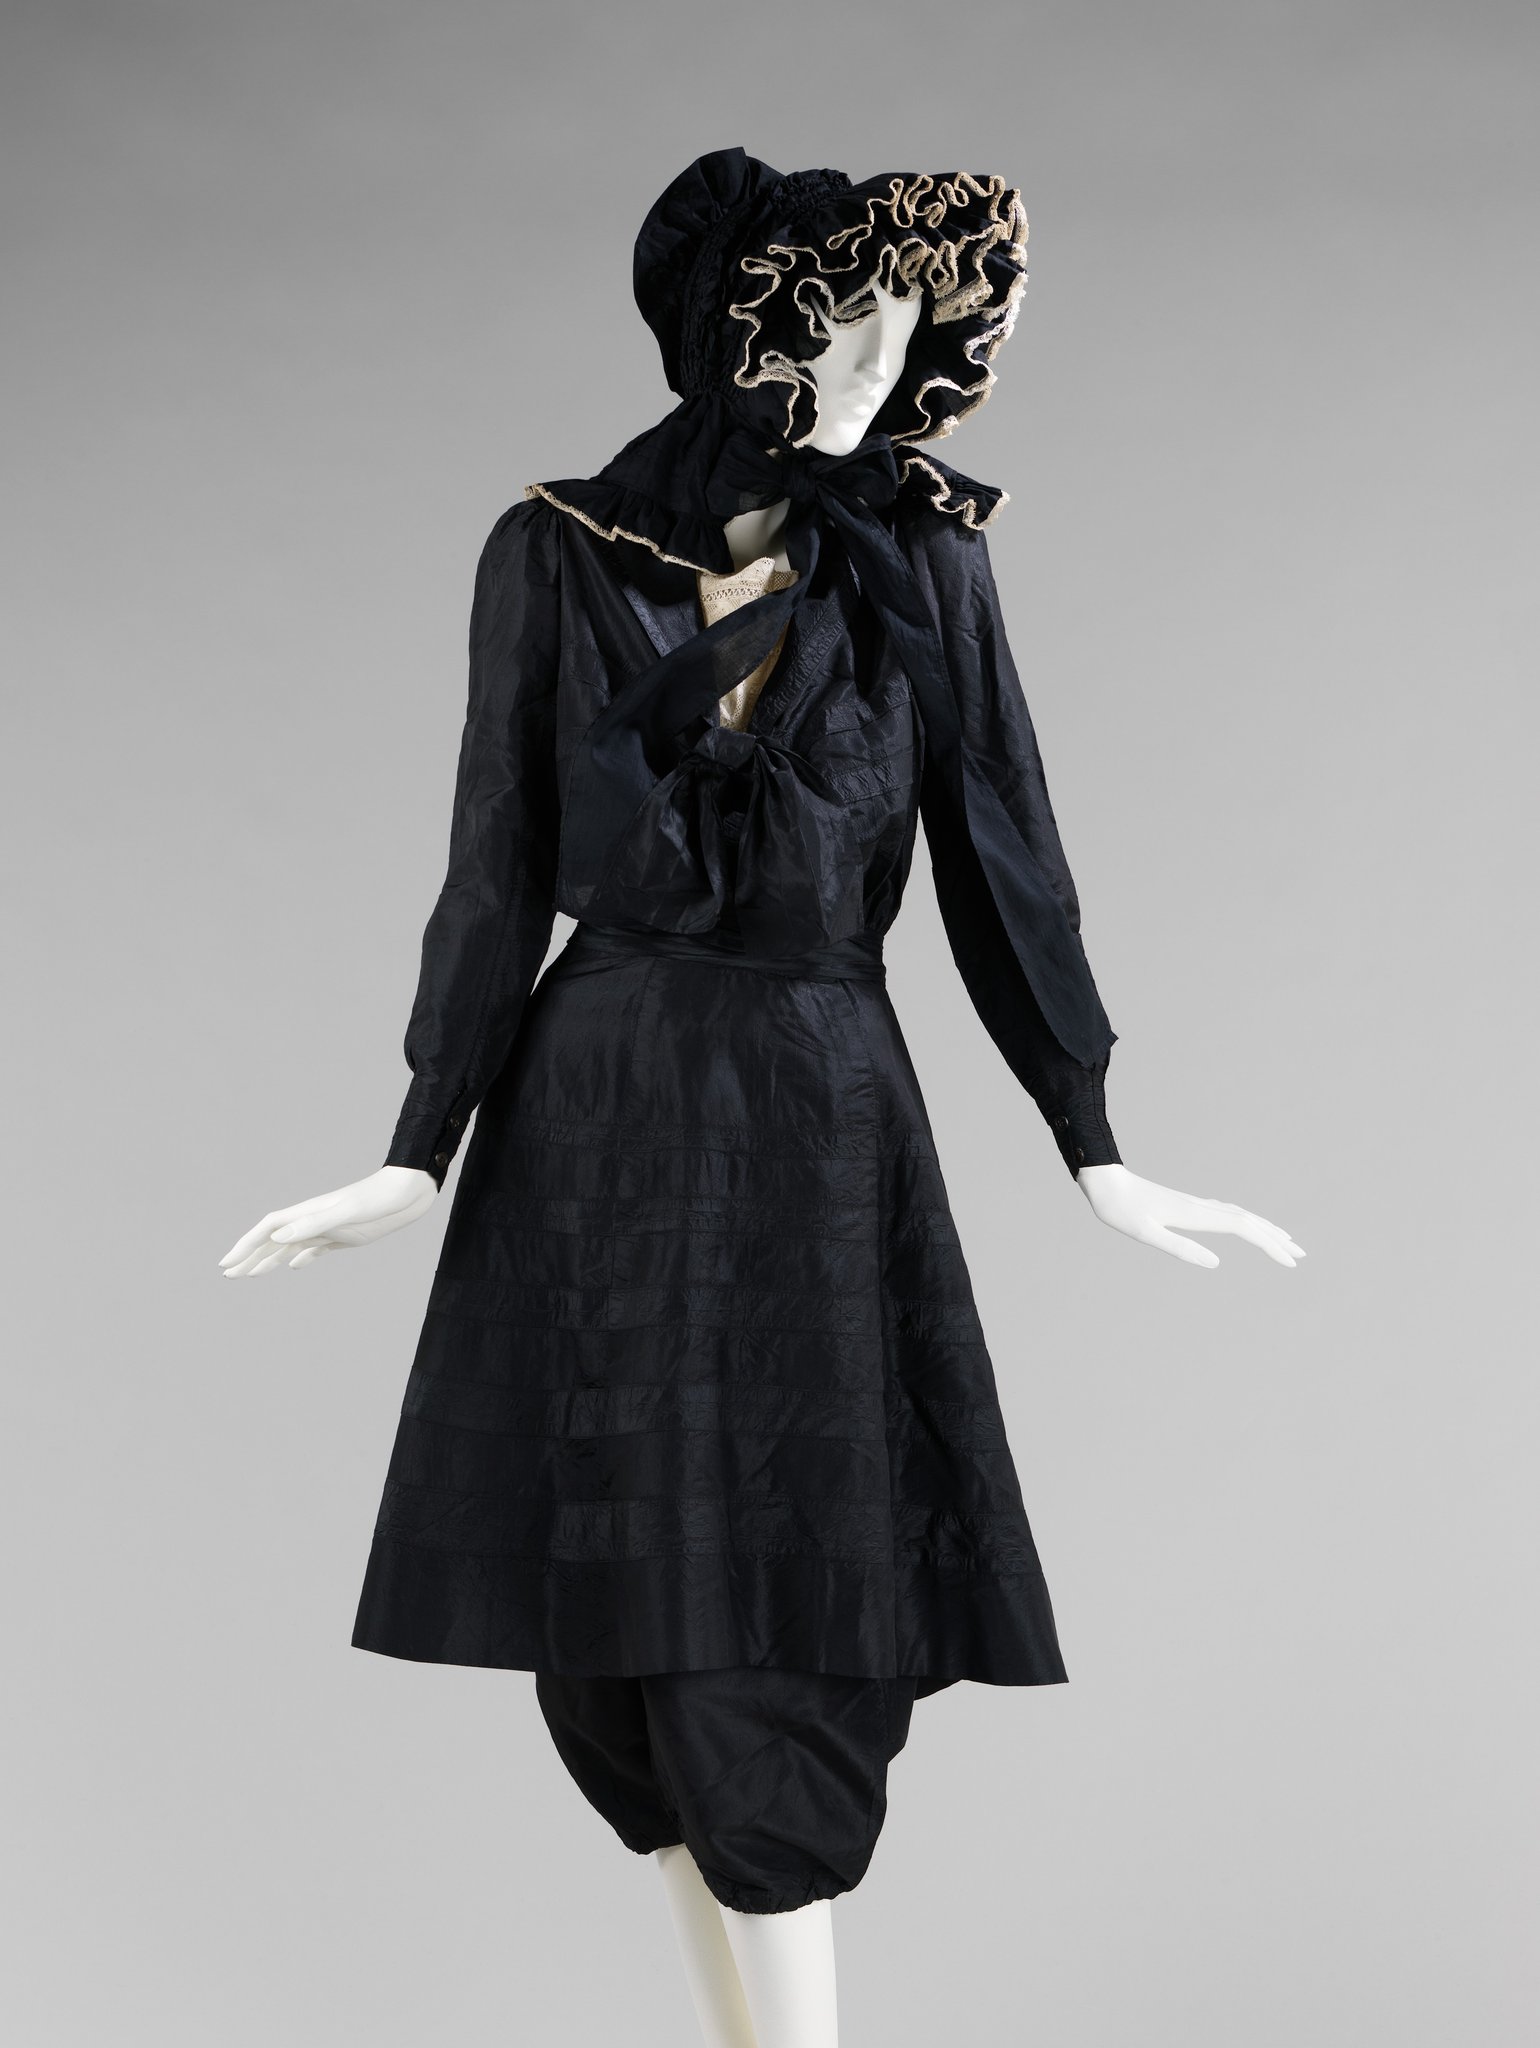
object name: beachwear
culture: french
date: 1895-1900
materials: cotton, mother of pearl, silk